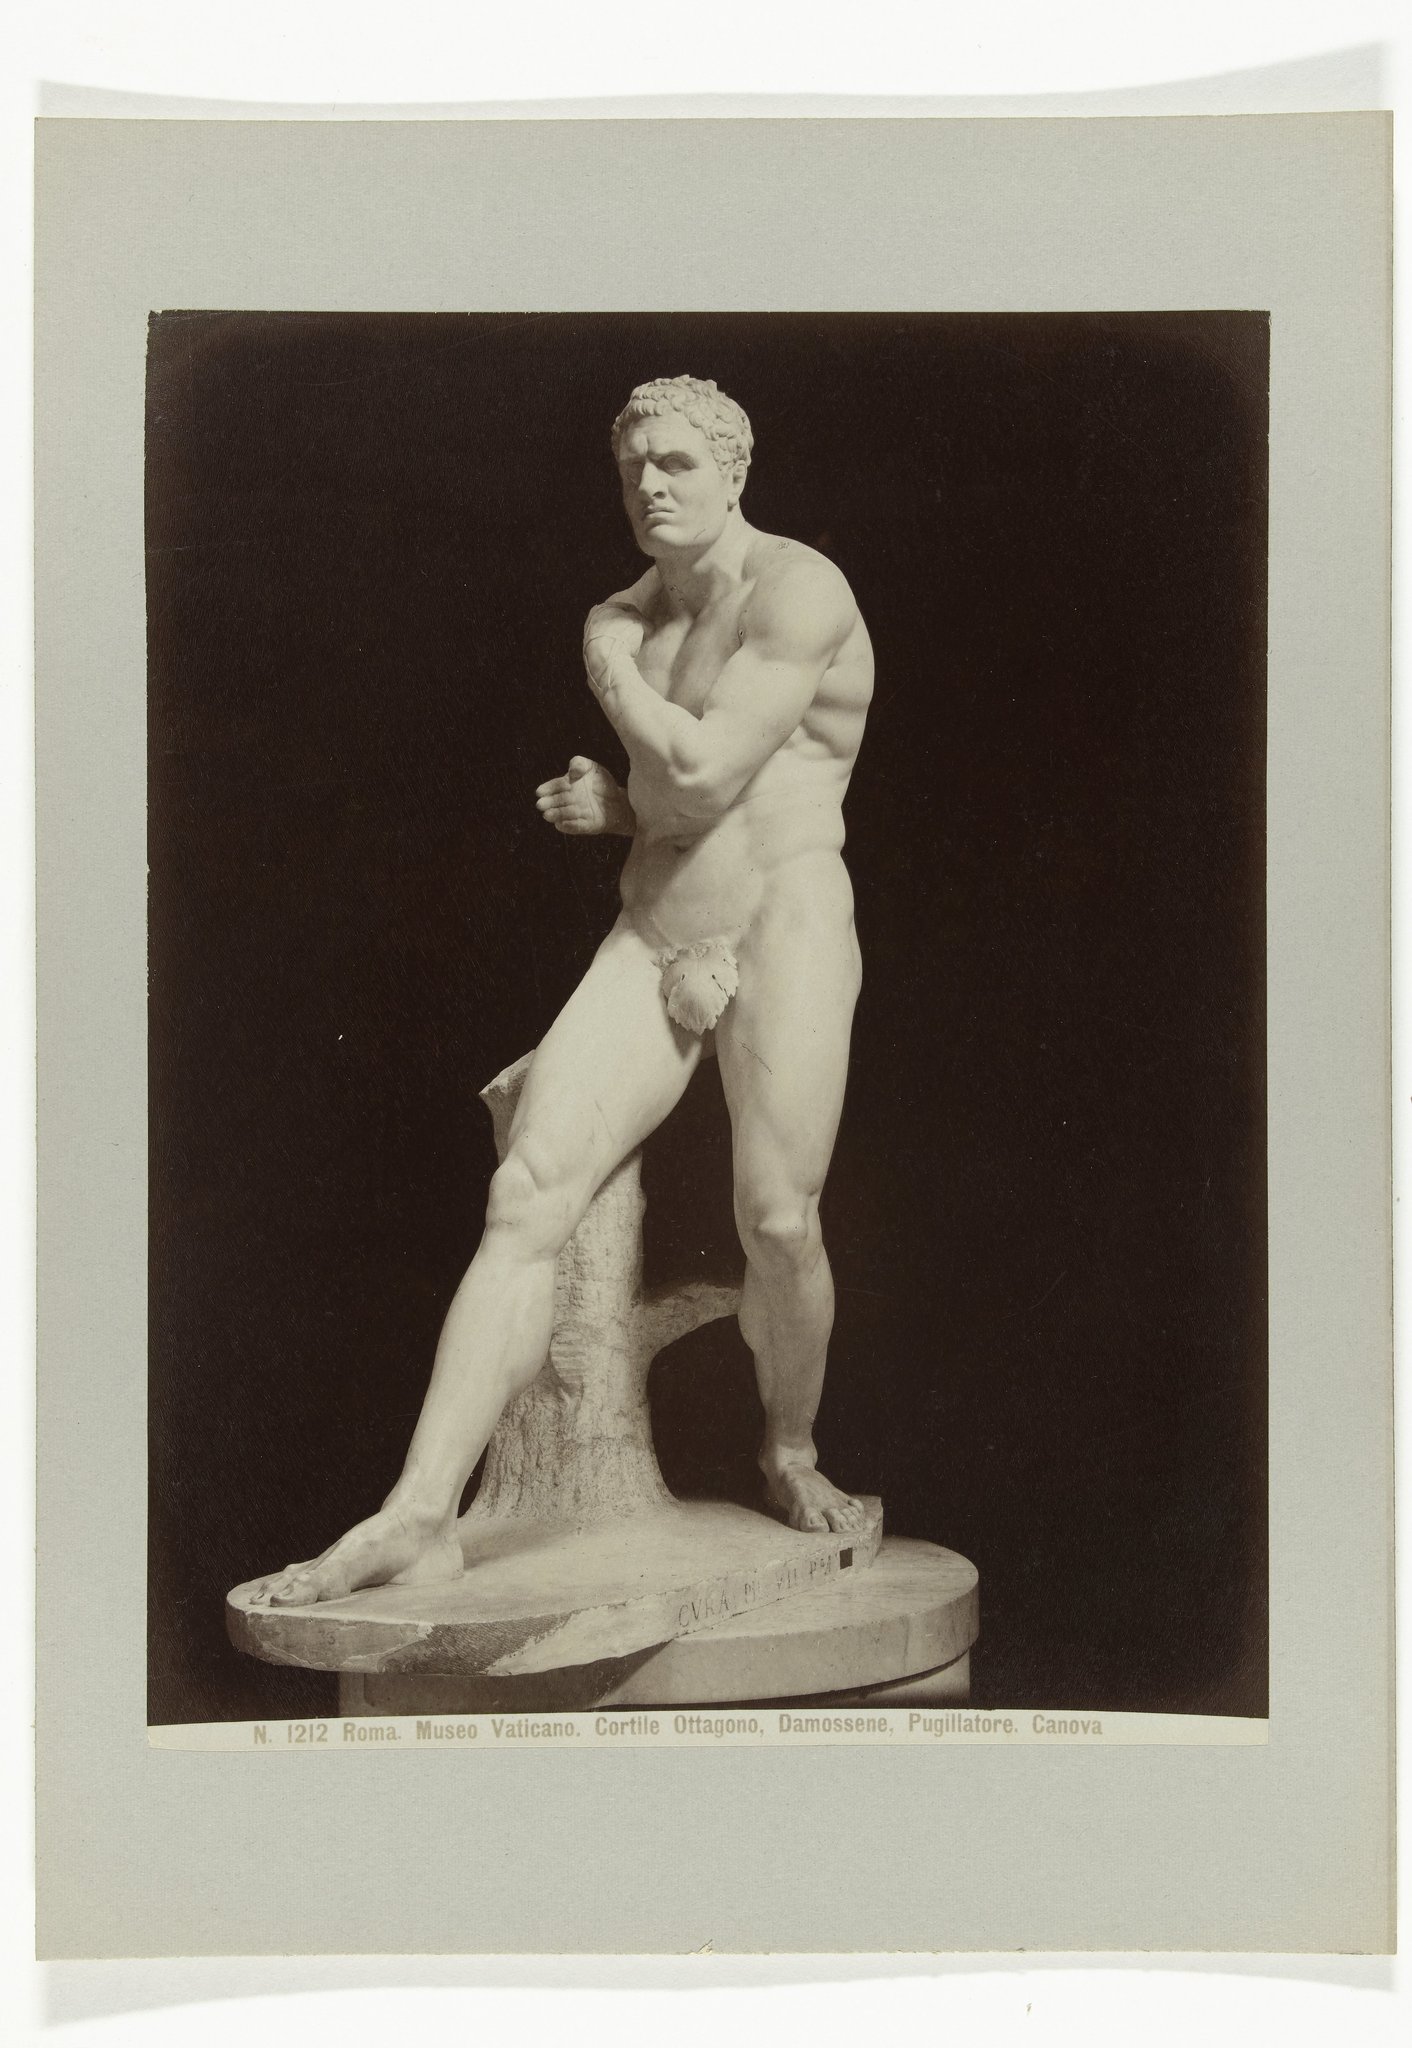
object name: photograph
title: N. 1212 Roma. Museo Vaticano. Cortile Ottagono, Damossene, Pugillatore. Canova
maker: Anonymous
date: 1880-1904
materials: cardboard, paper, photographic support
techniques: albumen print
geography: rome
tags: vaticaanse musea